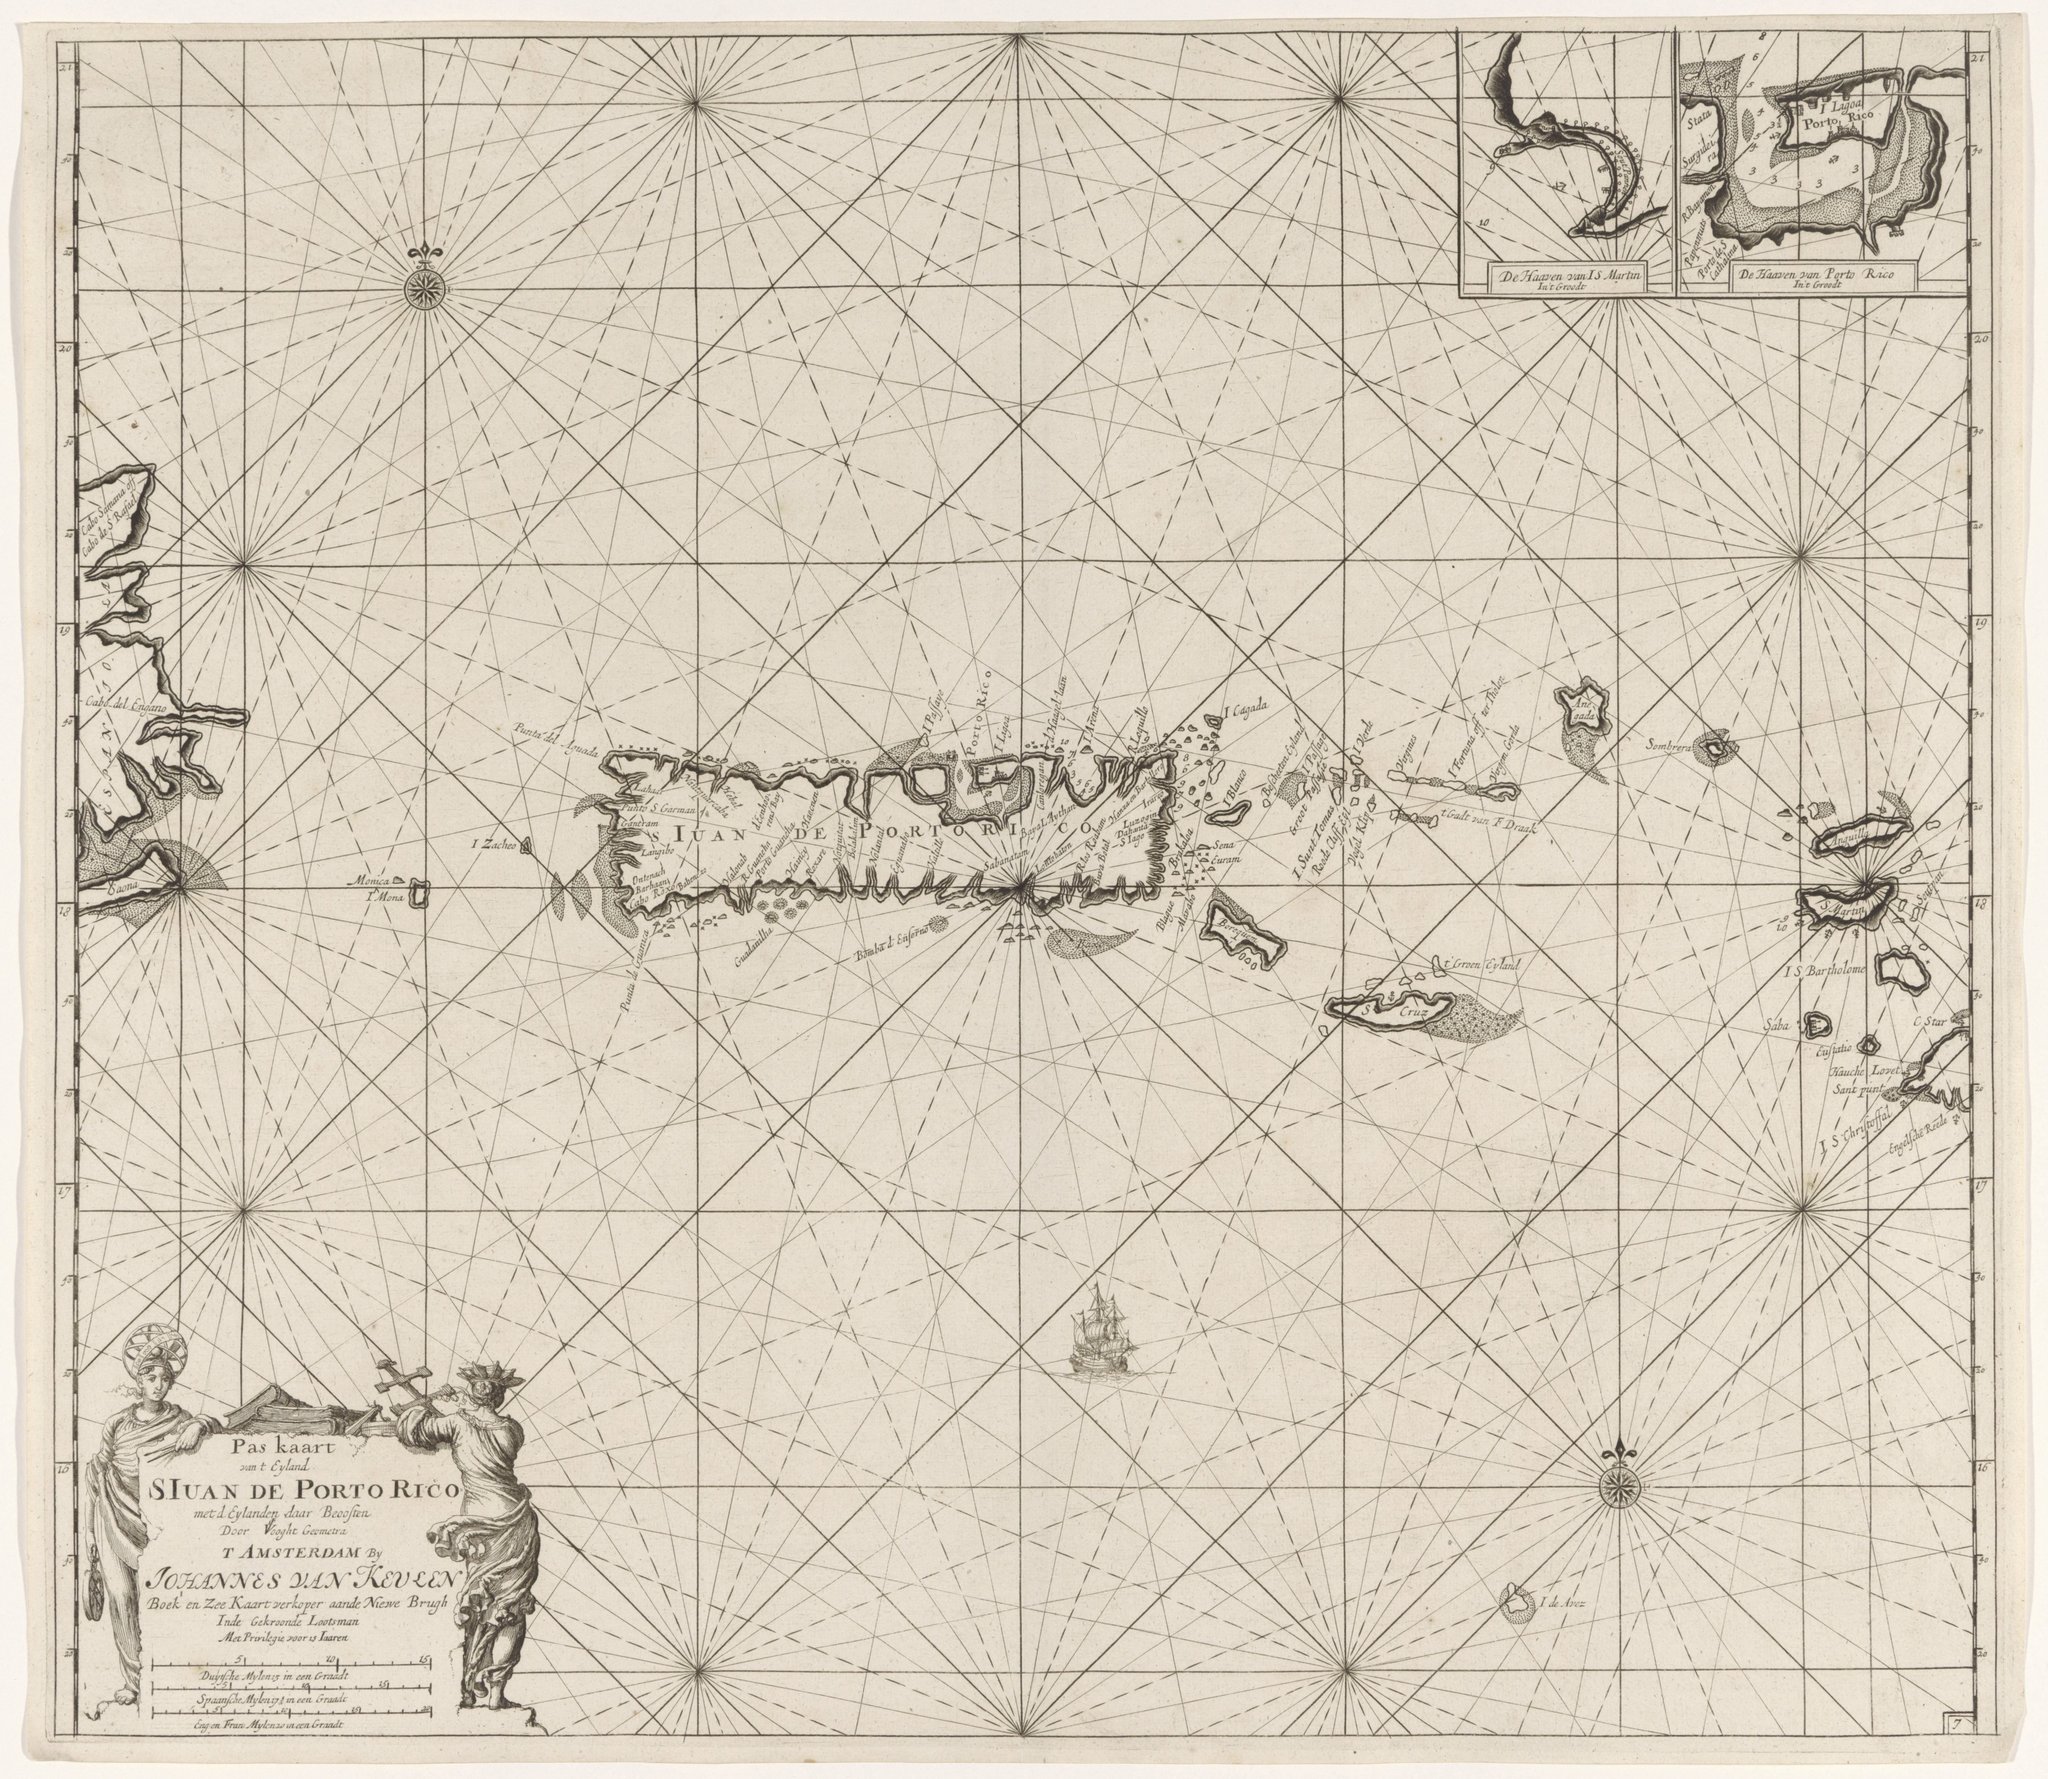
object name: print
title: Pas kaart van t Eyland S.Iuan De Porto Rico met d''Eylanden daar beoosten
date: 1684-1799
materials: paper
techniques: engraving, etching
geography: amsterdam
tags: armillary sphere, skeleton celestial globe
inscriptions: collector's mark: Lugt 2228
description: Paskaart van Puerto Rico, met inzetkaarten van St. Thomas en de haven Puerto Rico. Met twee windrozen, het Noorden ligt boven. Linksonder de titel, het adres van de uitgever en de schaalverdeling, weergegeven in Duitse, Spaanse en Engelse of Franse mijlen (schaal: c. 1:1.300.000). De gegevens zijn geflankeerd door een vrouw met een schepenkroon en een jakobsstaf en een vrouw met een armillarium op het hoofd.